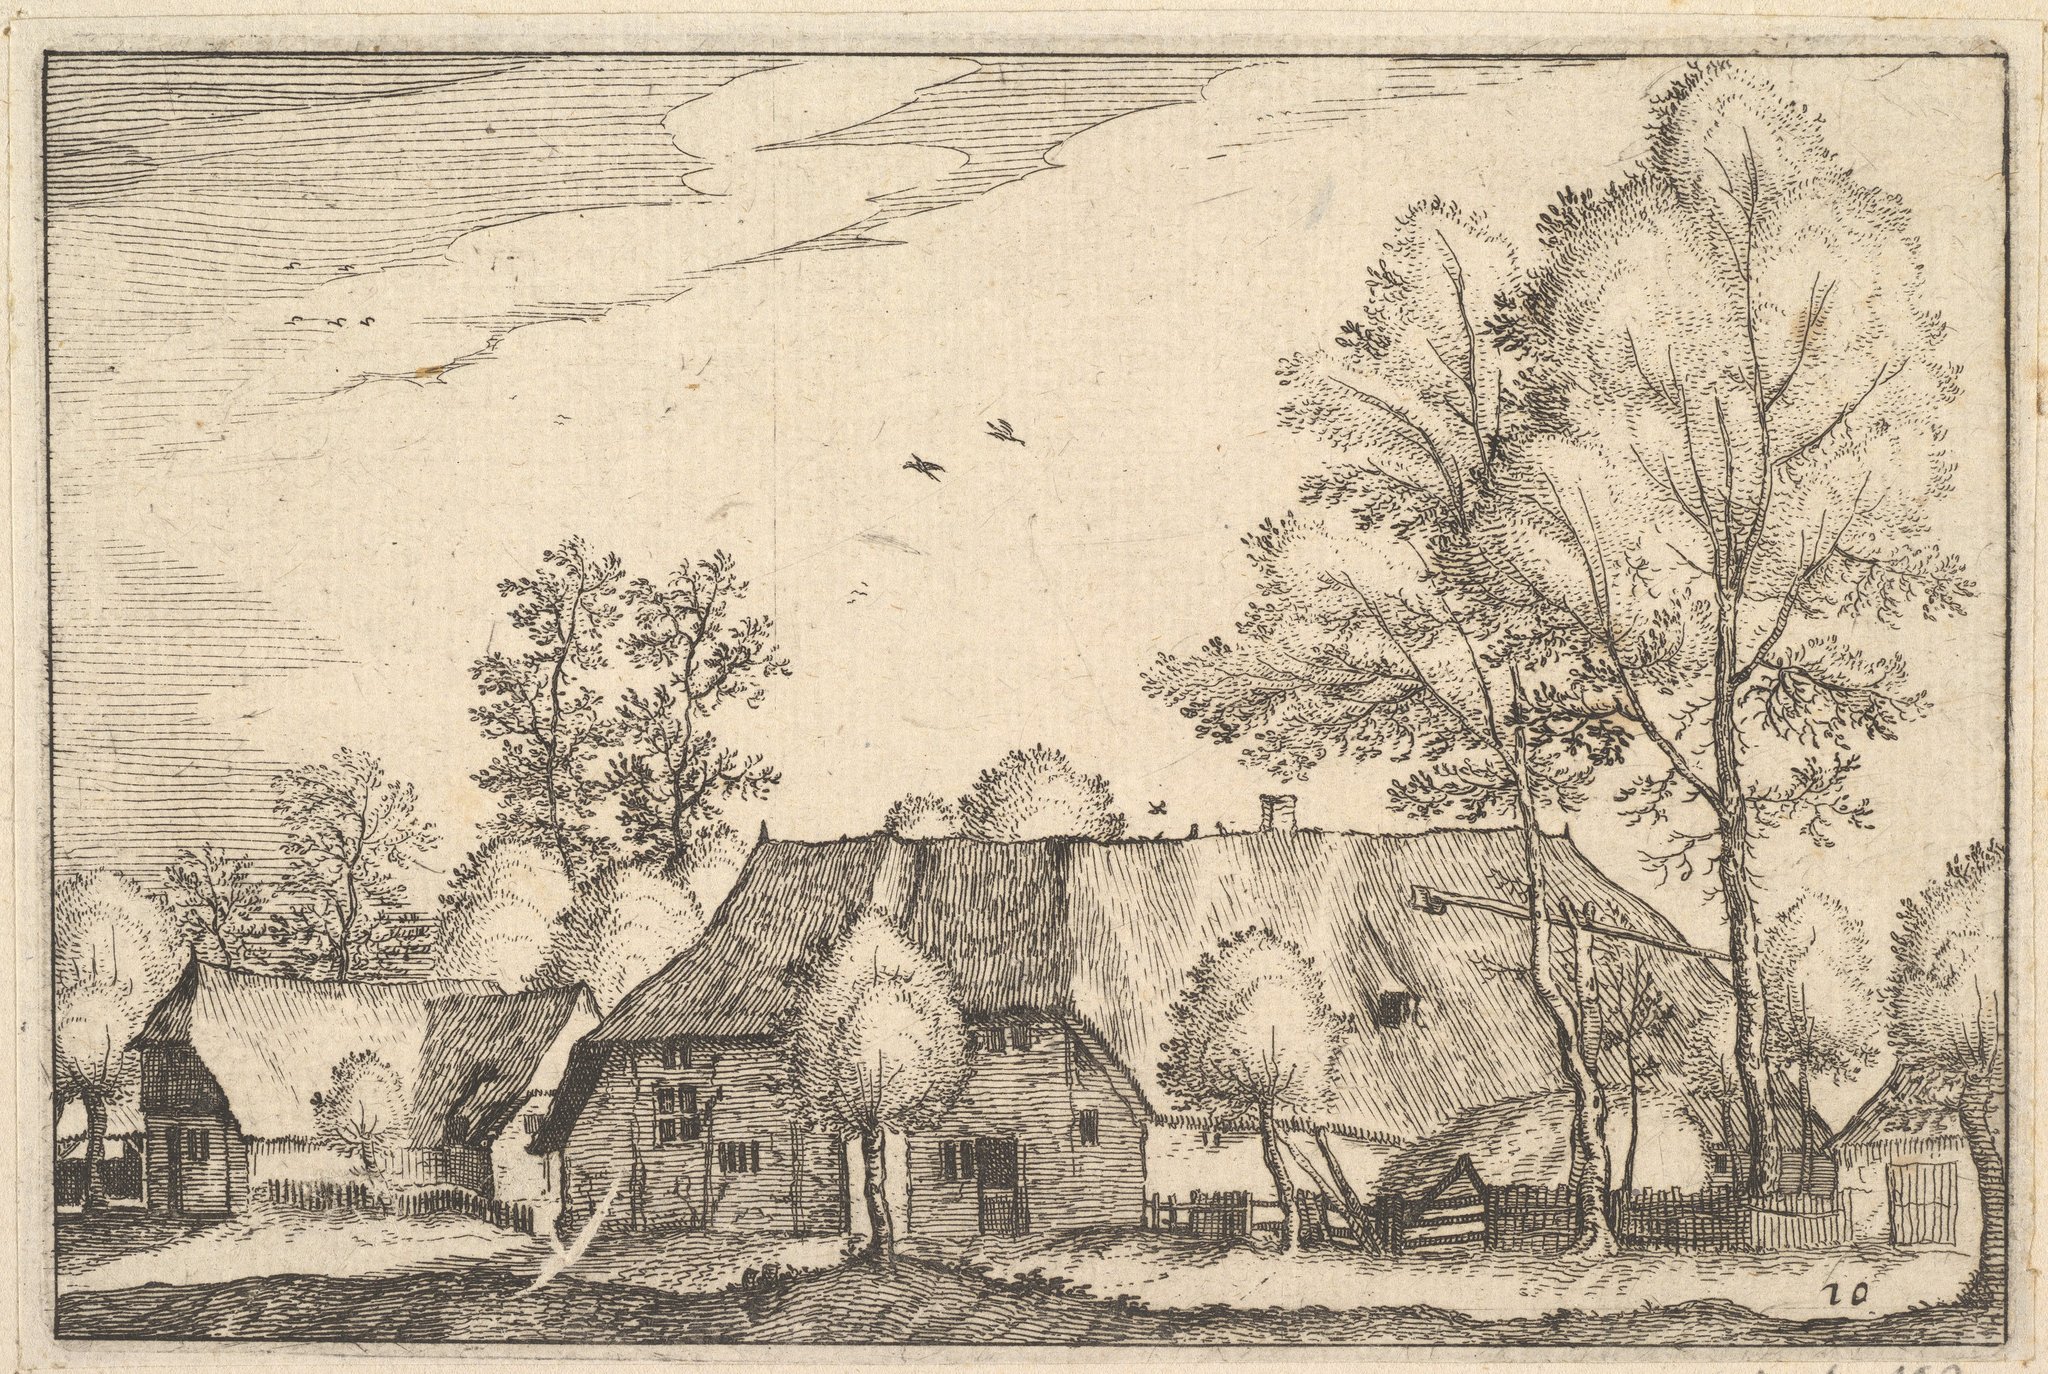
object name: print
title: Large Farm, plate 10 from "Regiunculae et Villae Aliquot Ducatus Brabantiae"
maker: claes jansz. visscher (ii)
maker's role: artist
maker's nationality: dutch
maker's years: 1586-1652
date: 1610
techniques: etching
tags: houses